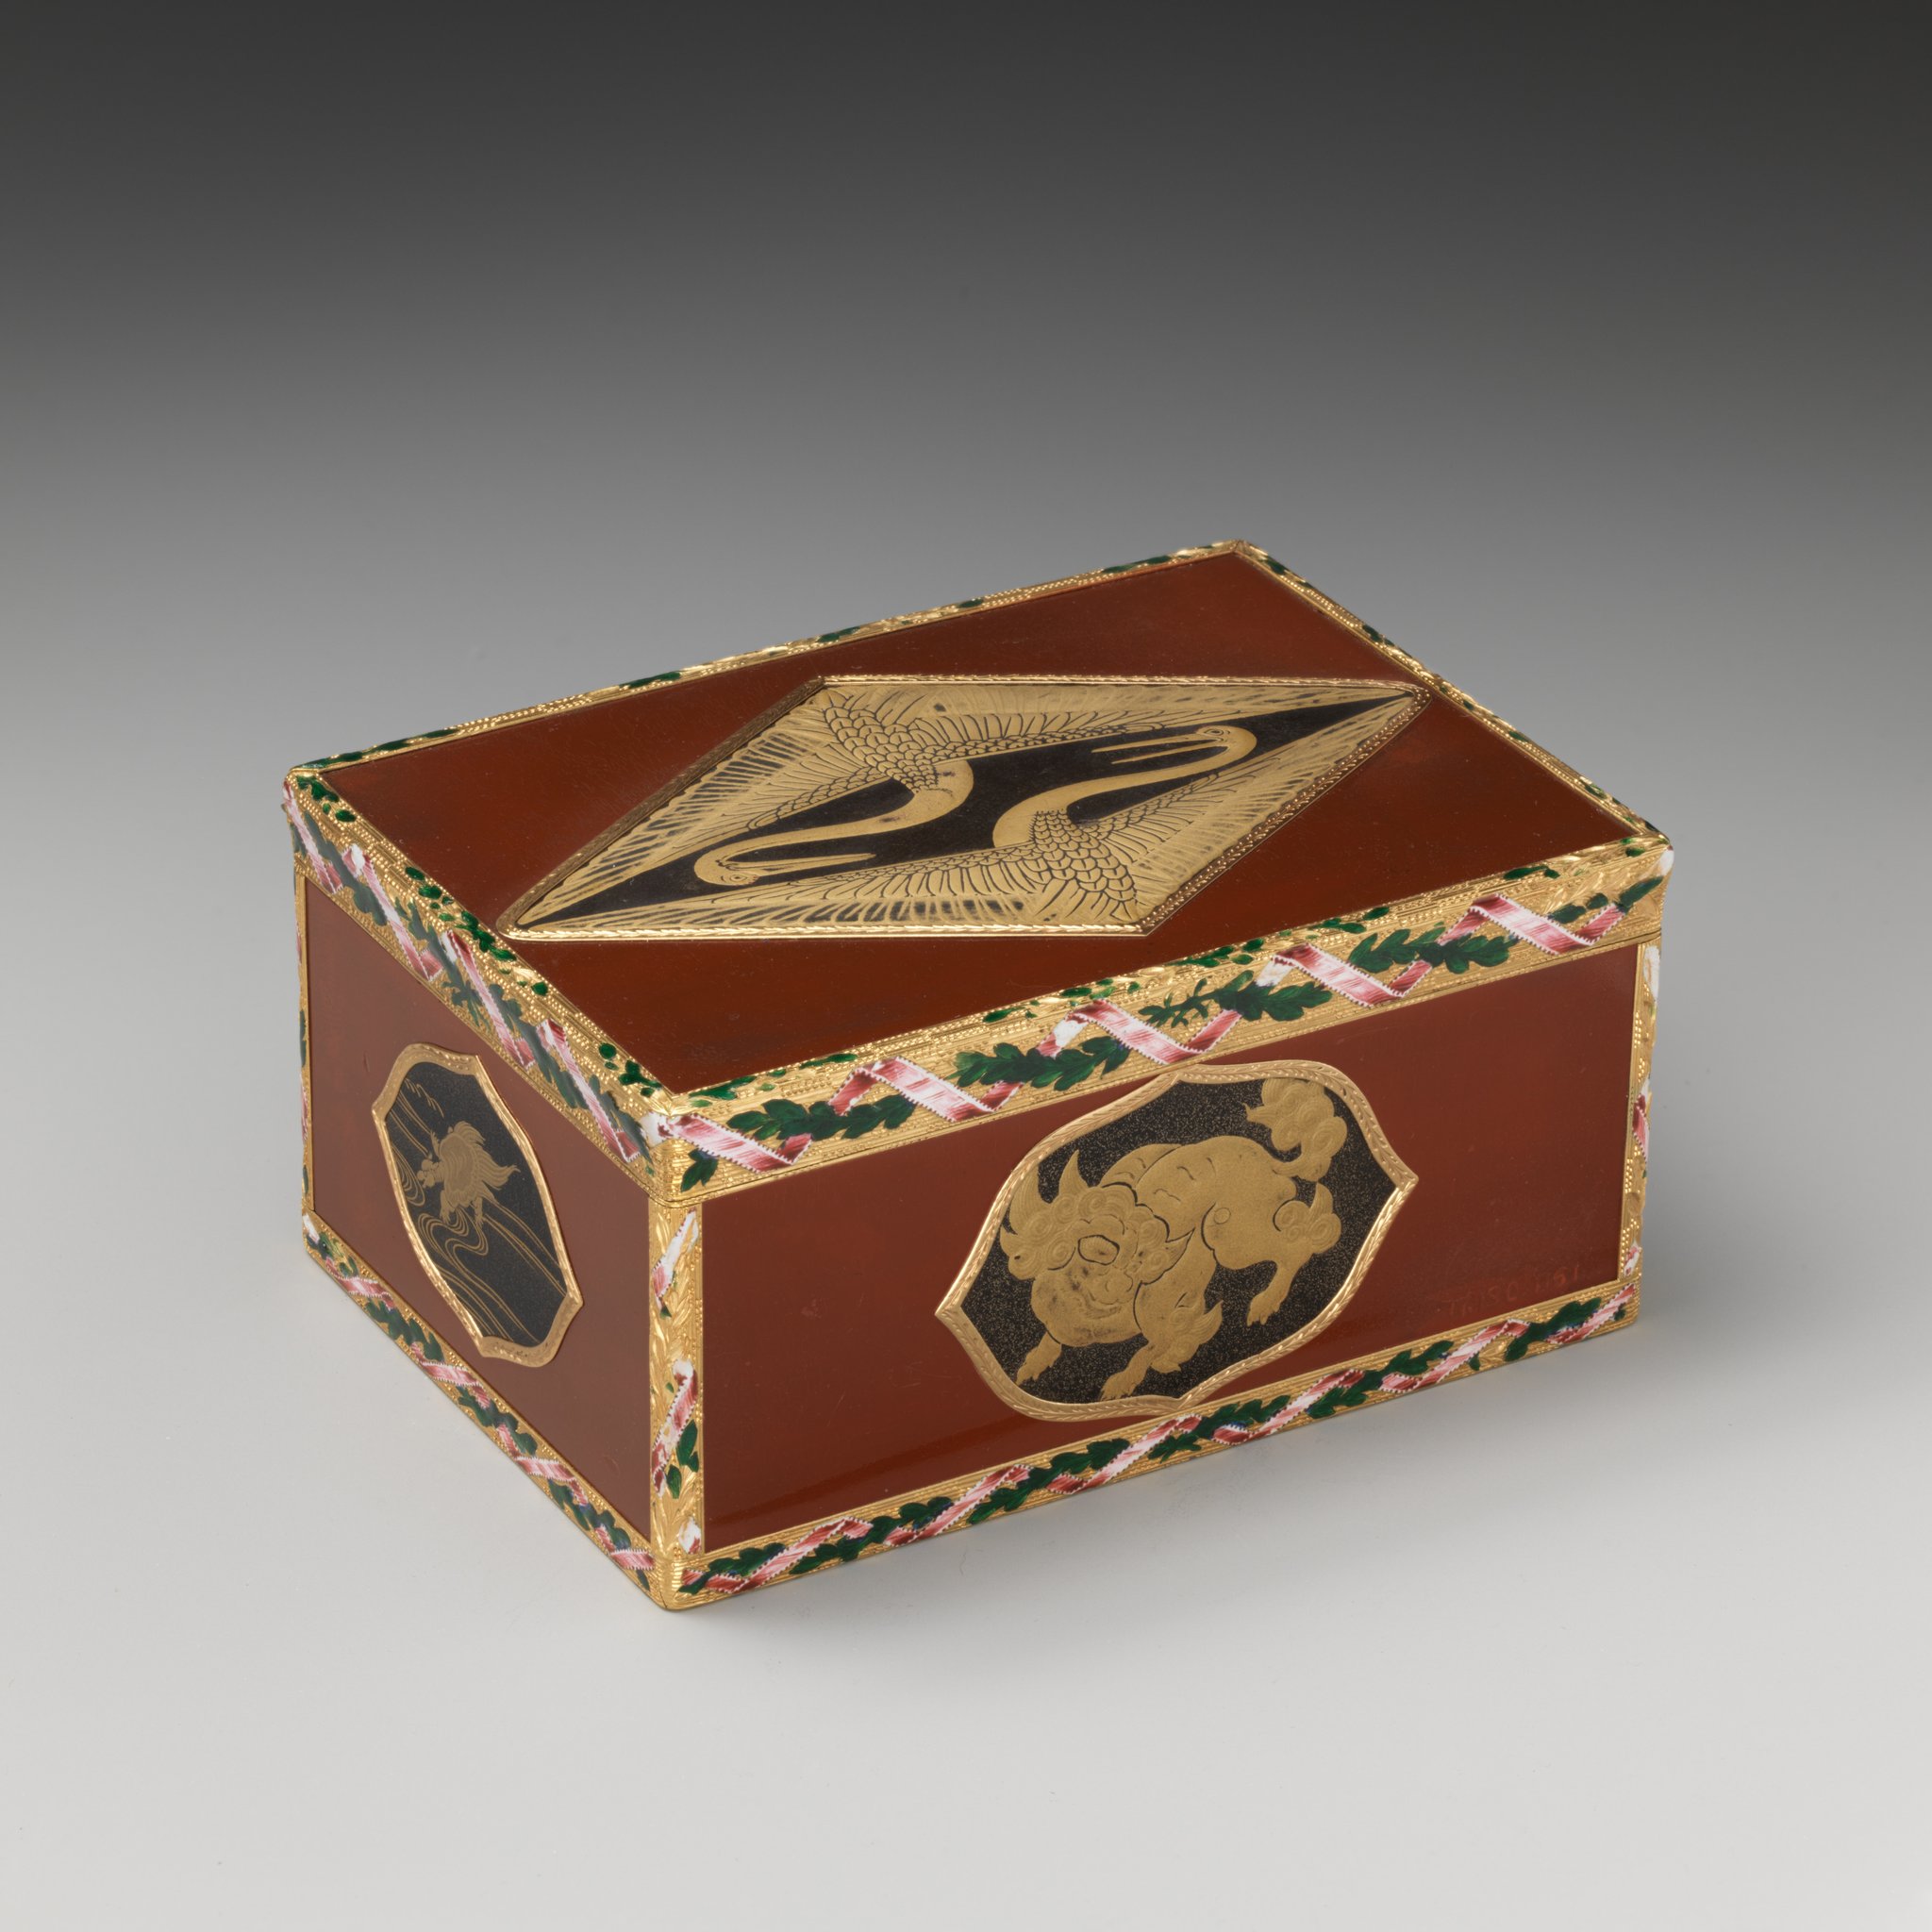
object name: snuffbox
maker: jean ducrollay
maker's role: maker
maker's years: 1709-1760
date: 1753-1754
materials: enamel, gold, lacquer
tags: animals,cranes